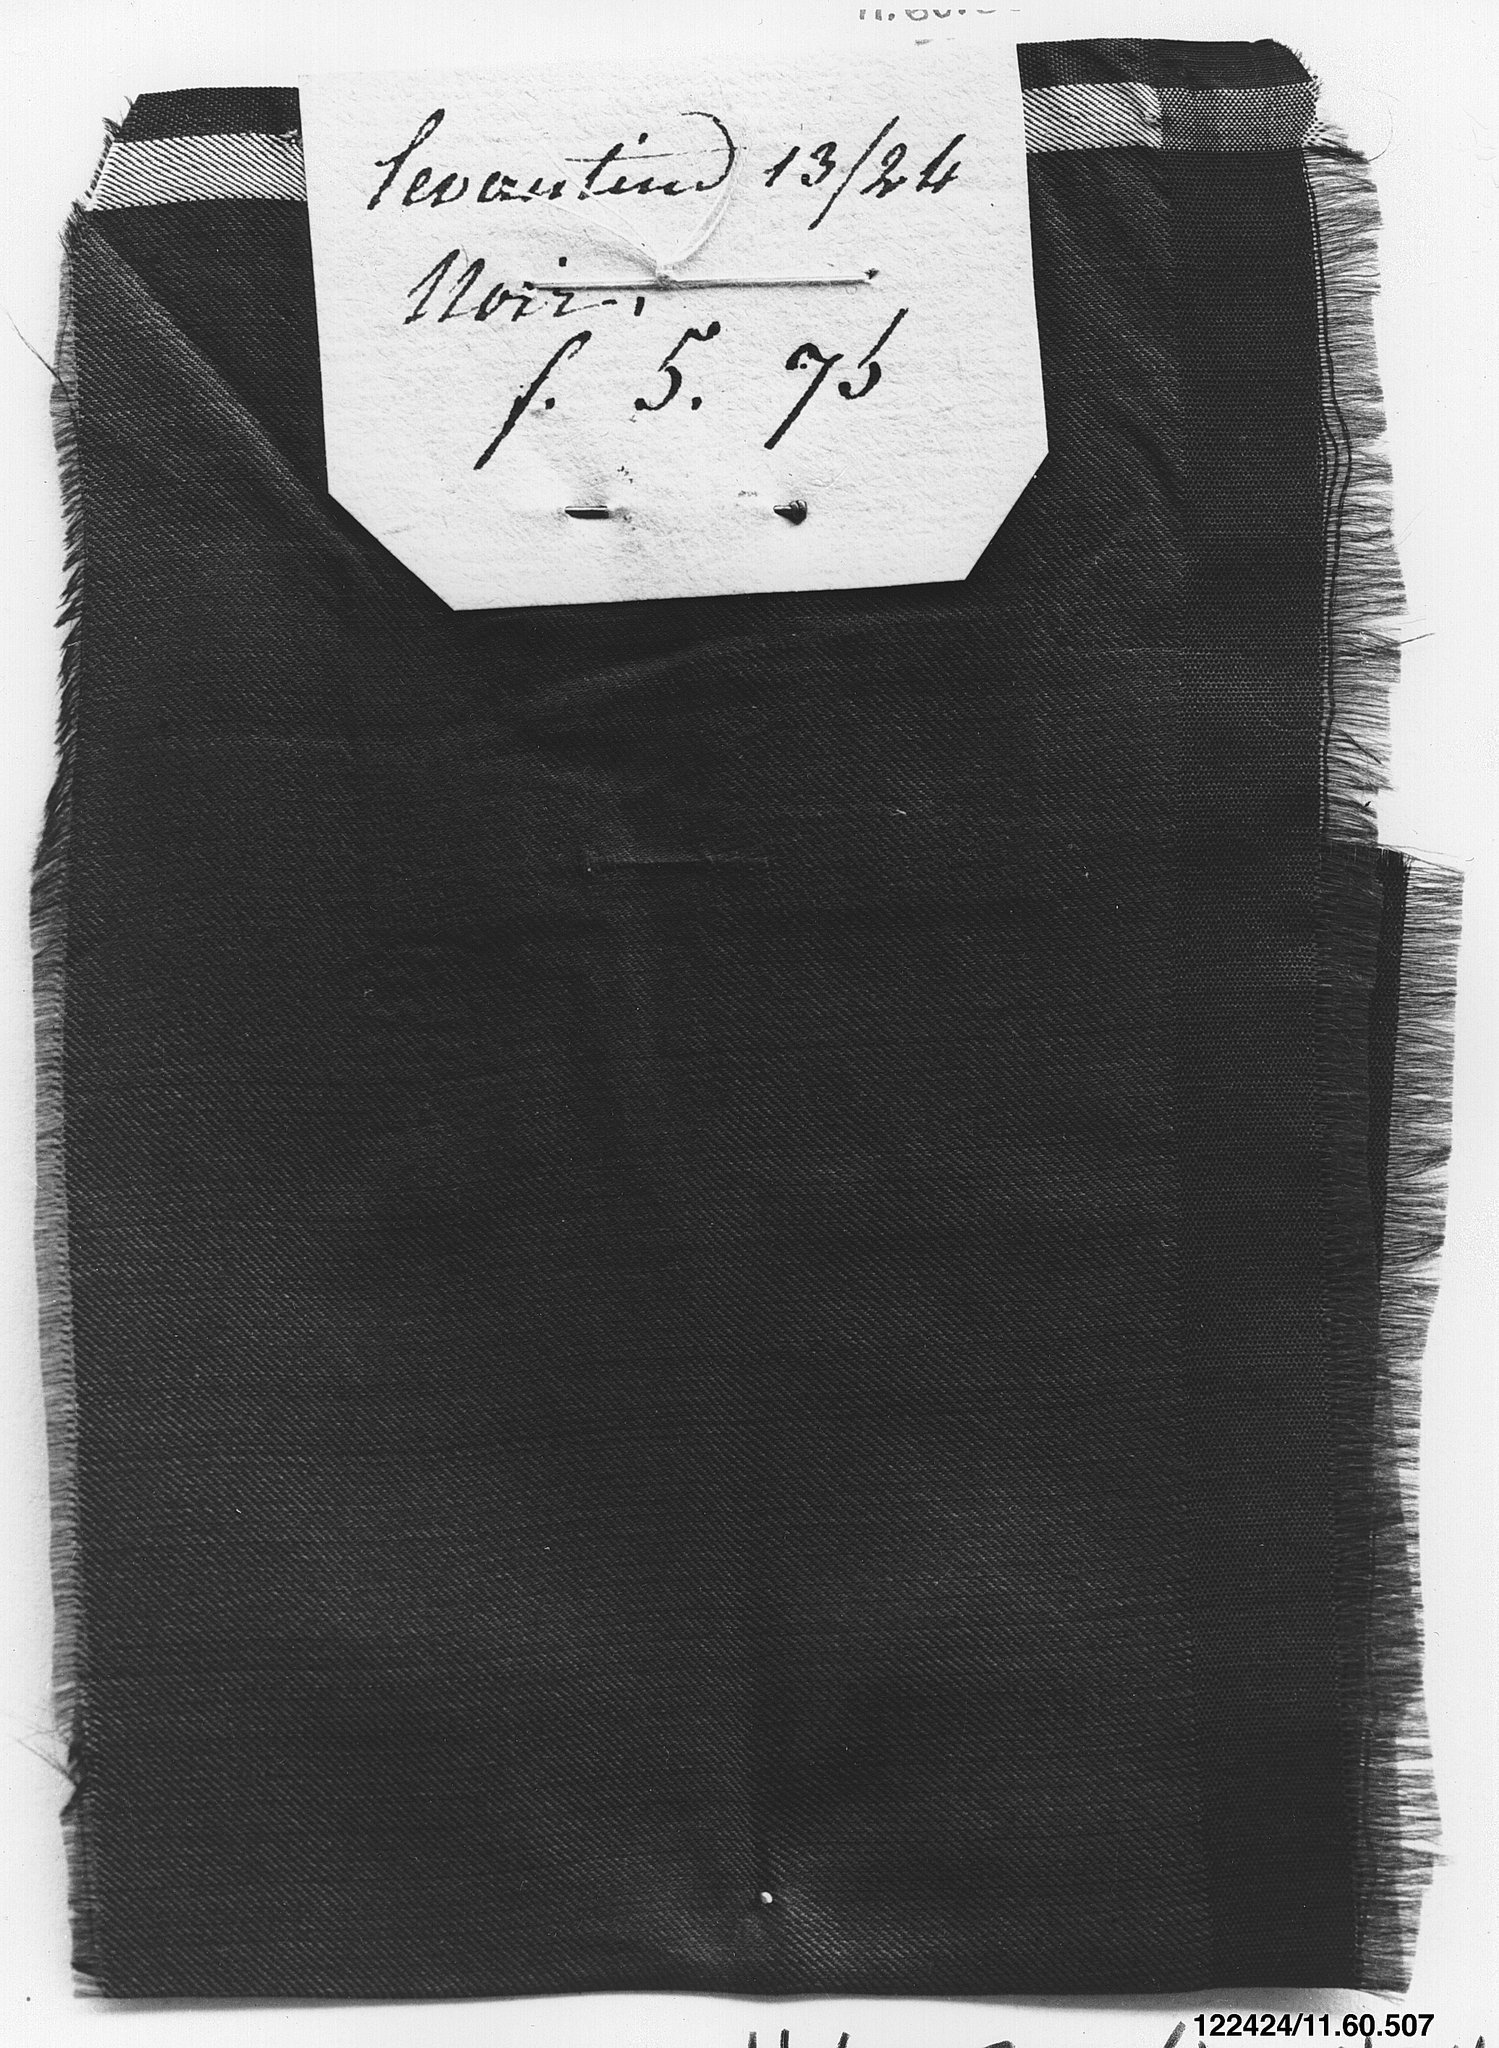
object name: sample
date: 1801-1850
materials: silk